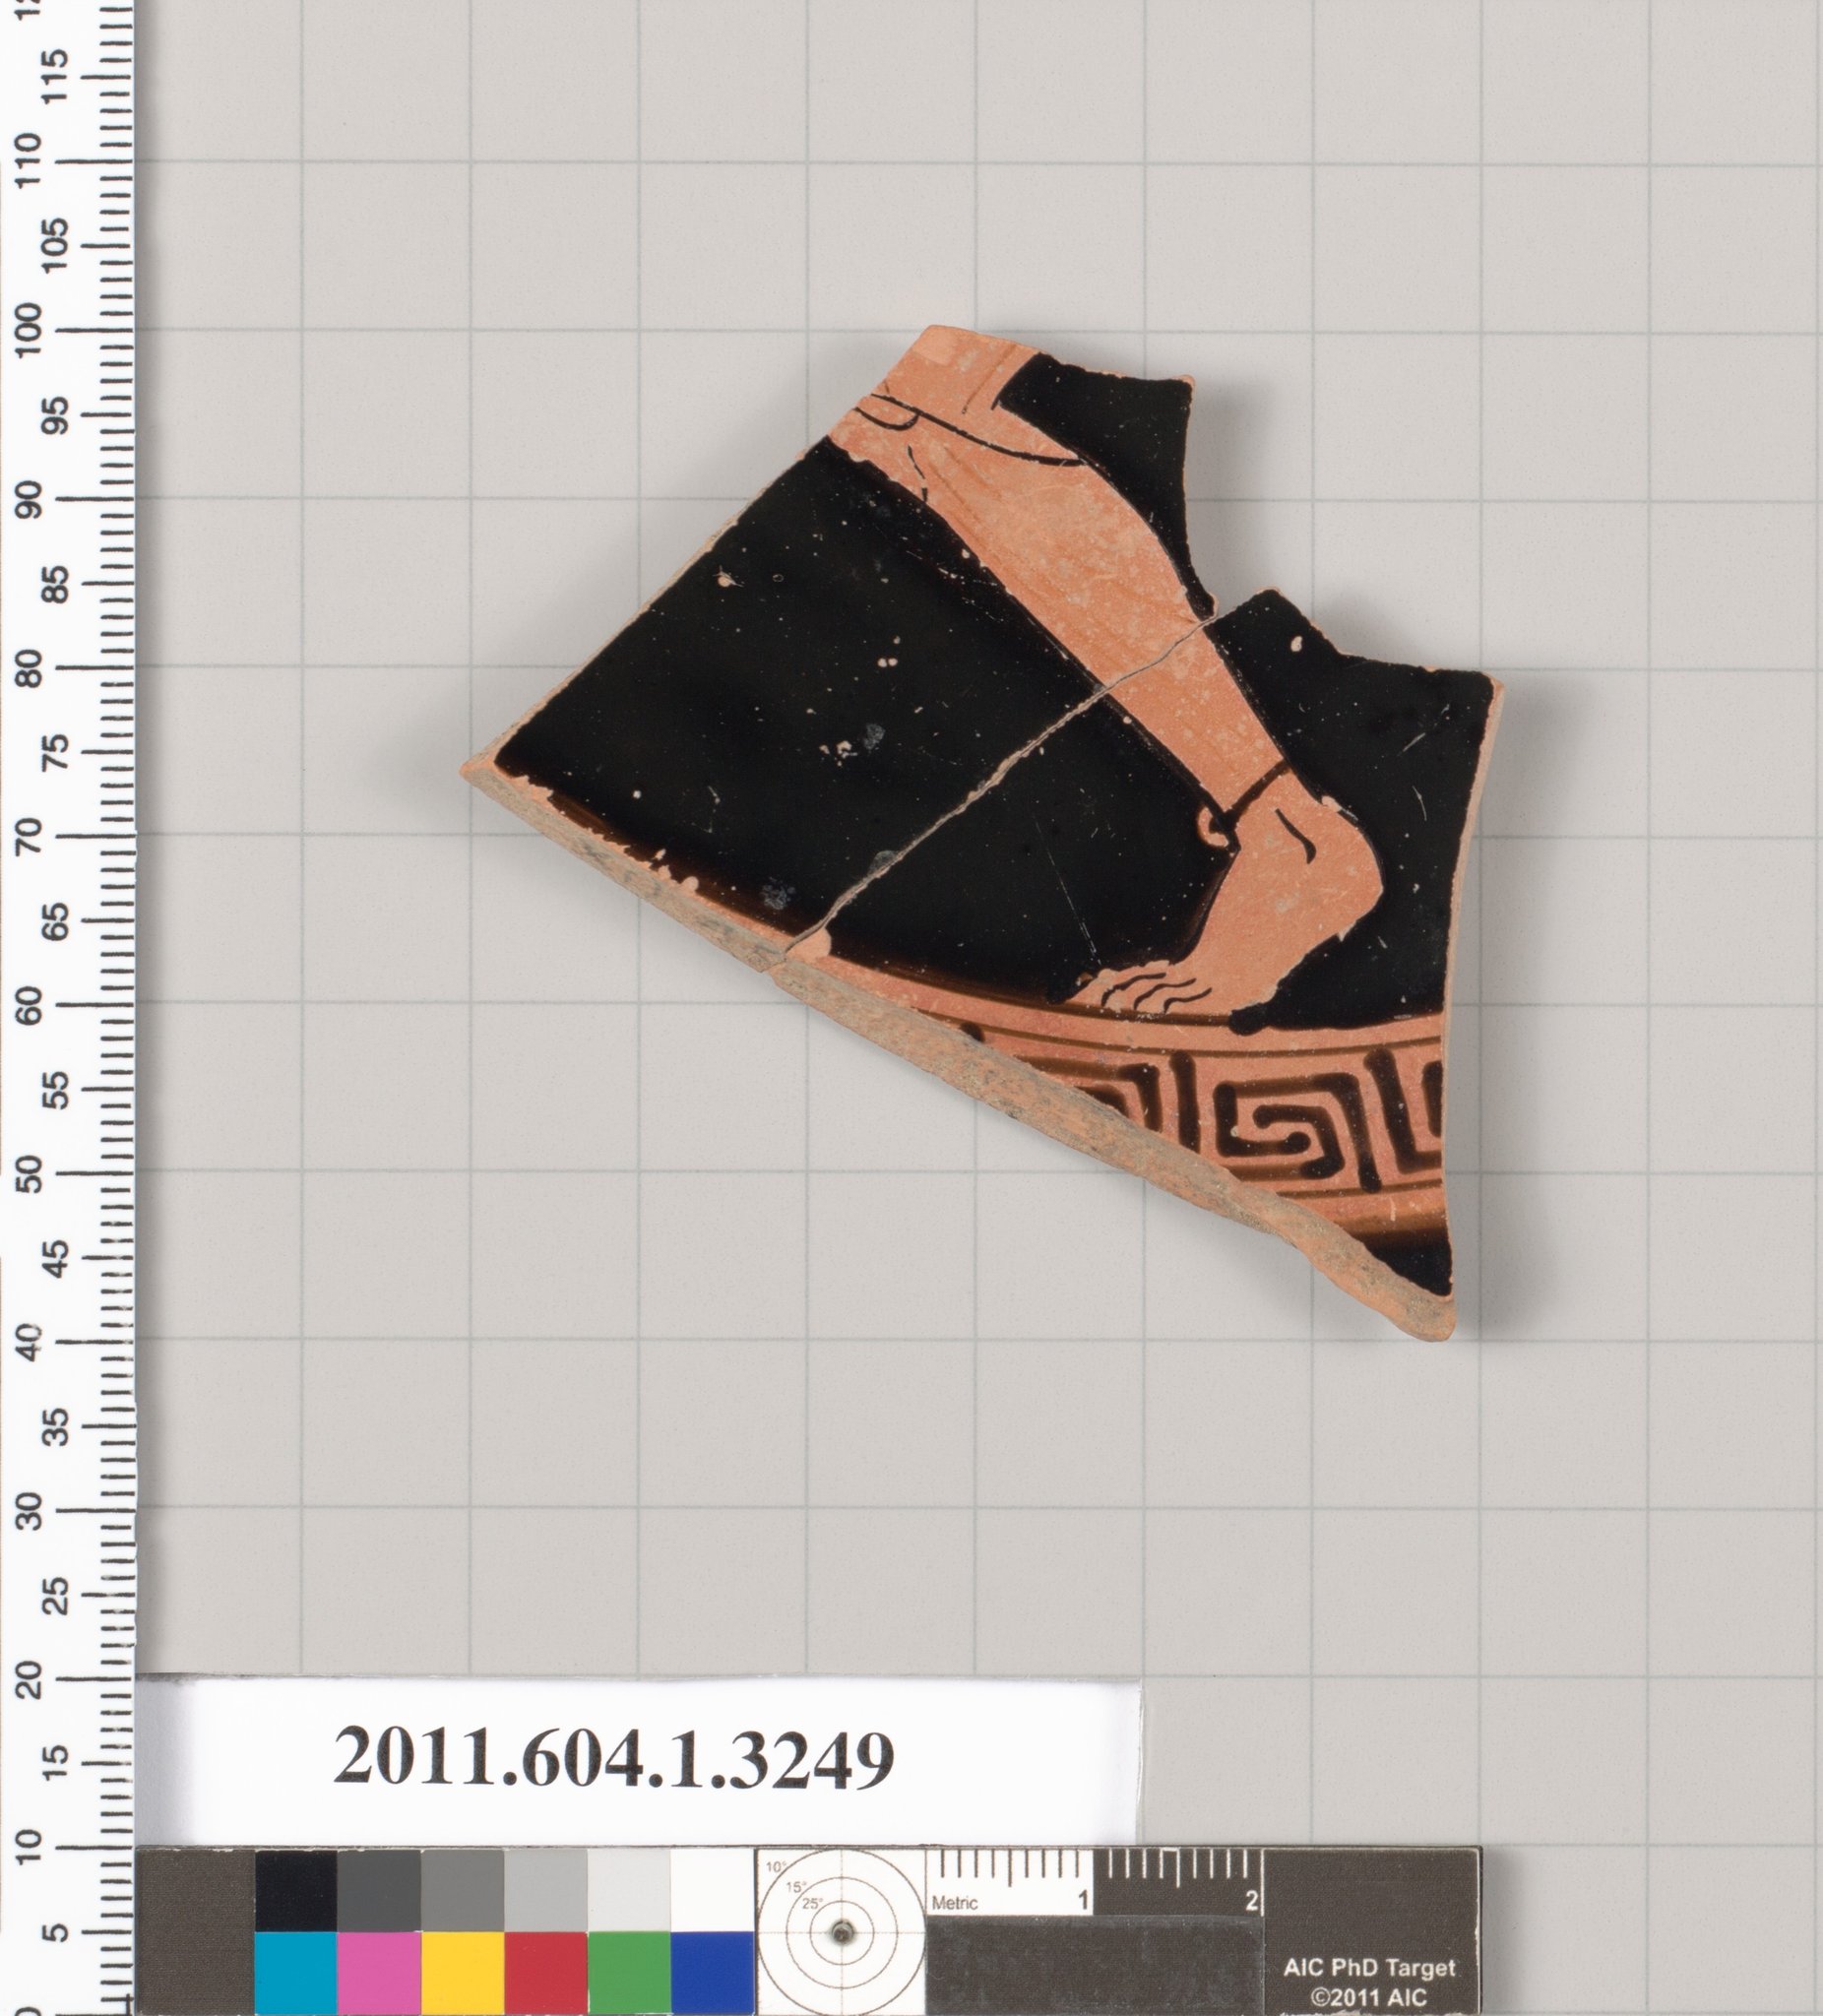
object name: kylix fragment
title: Terracotta fragment of a kylix (drinking cup)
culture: greek, attic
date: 480-470 BCE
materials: terracotta